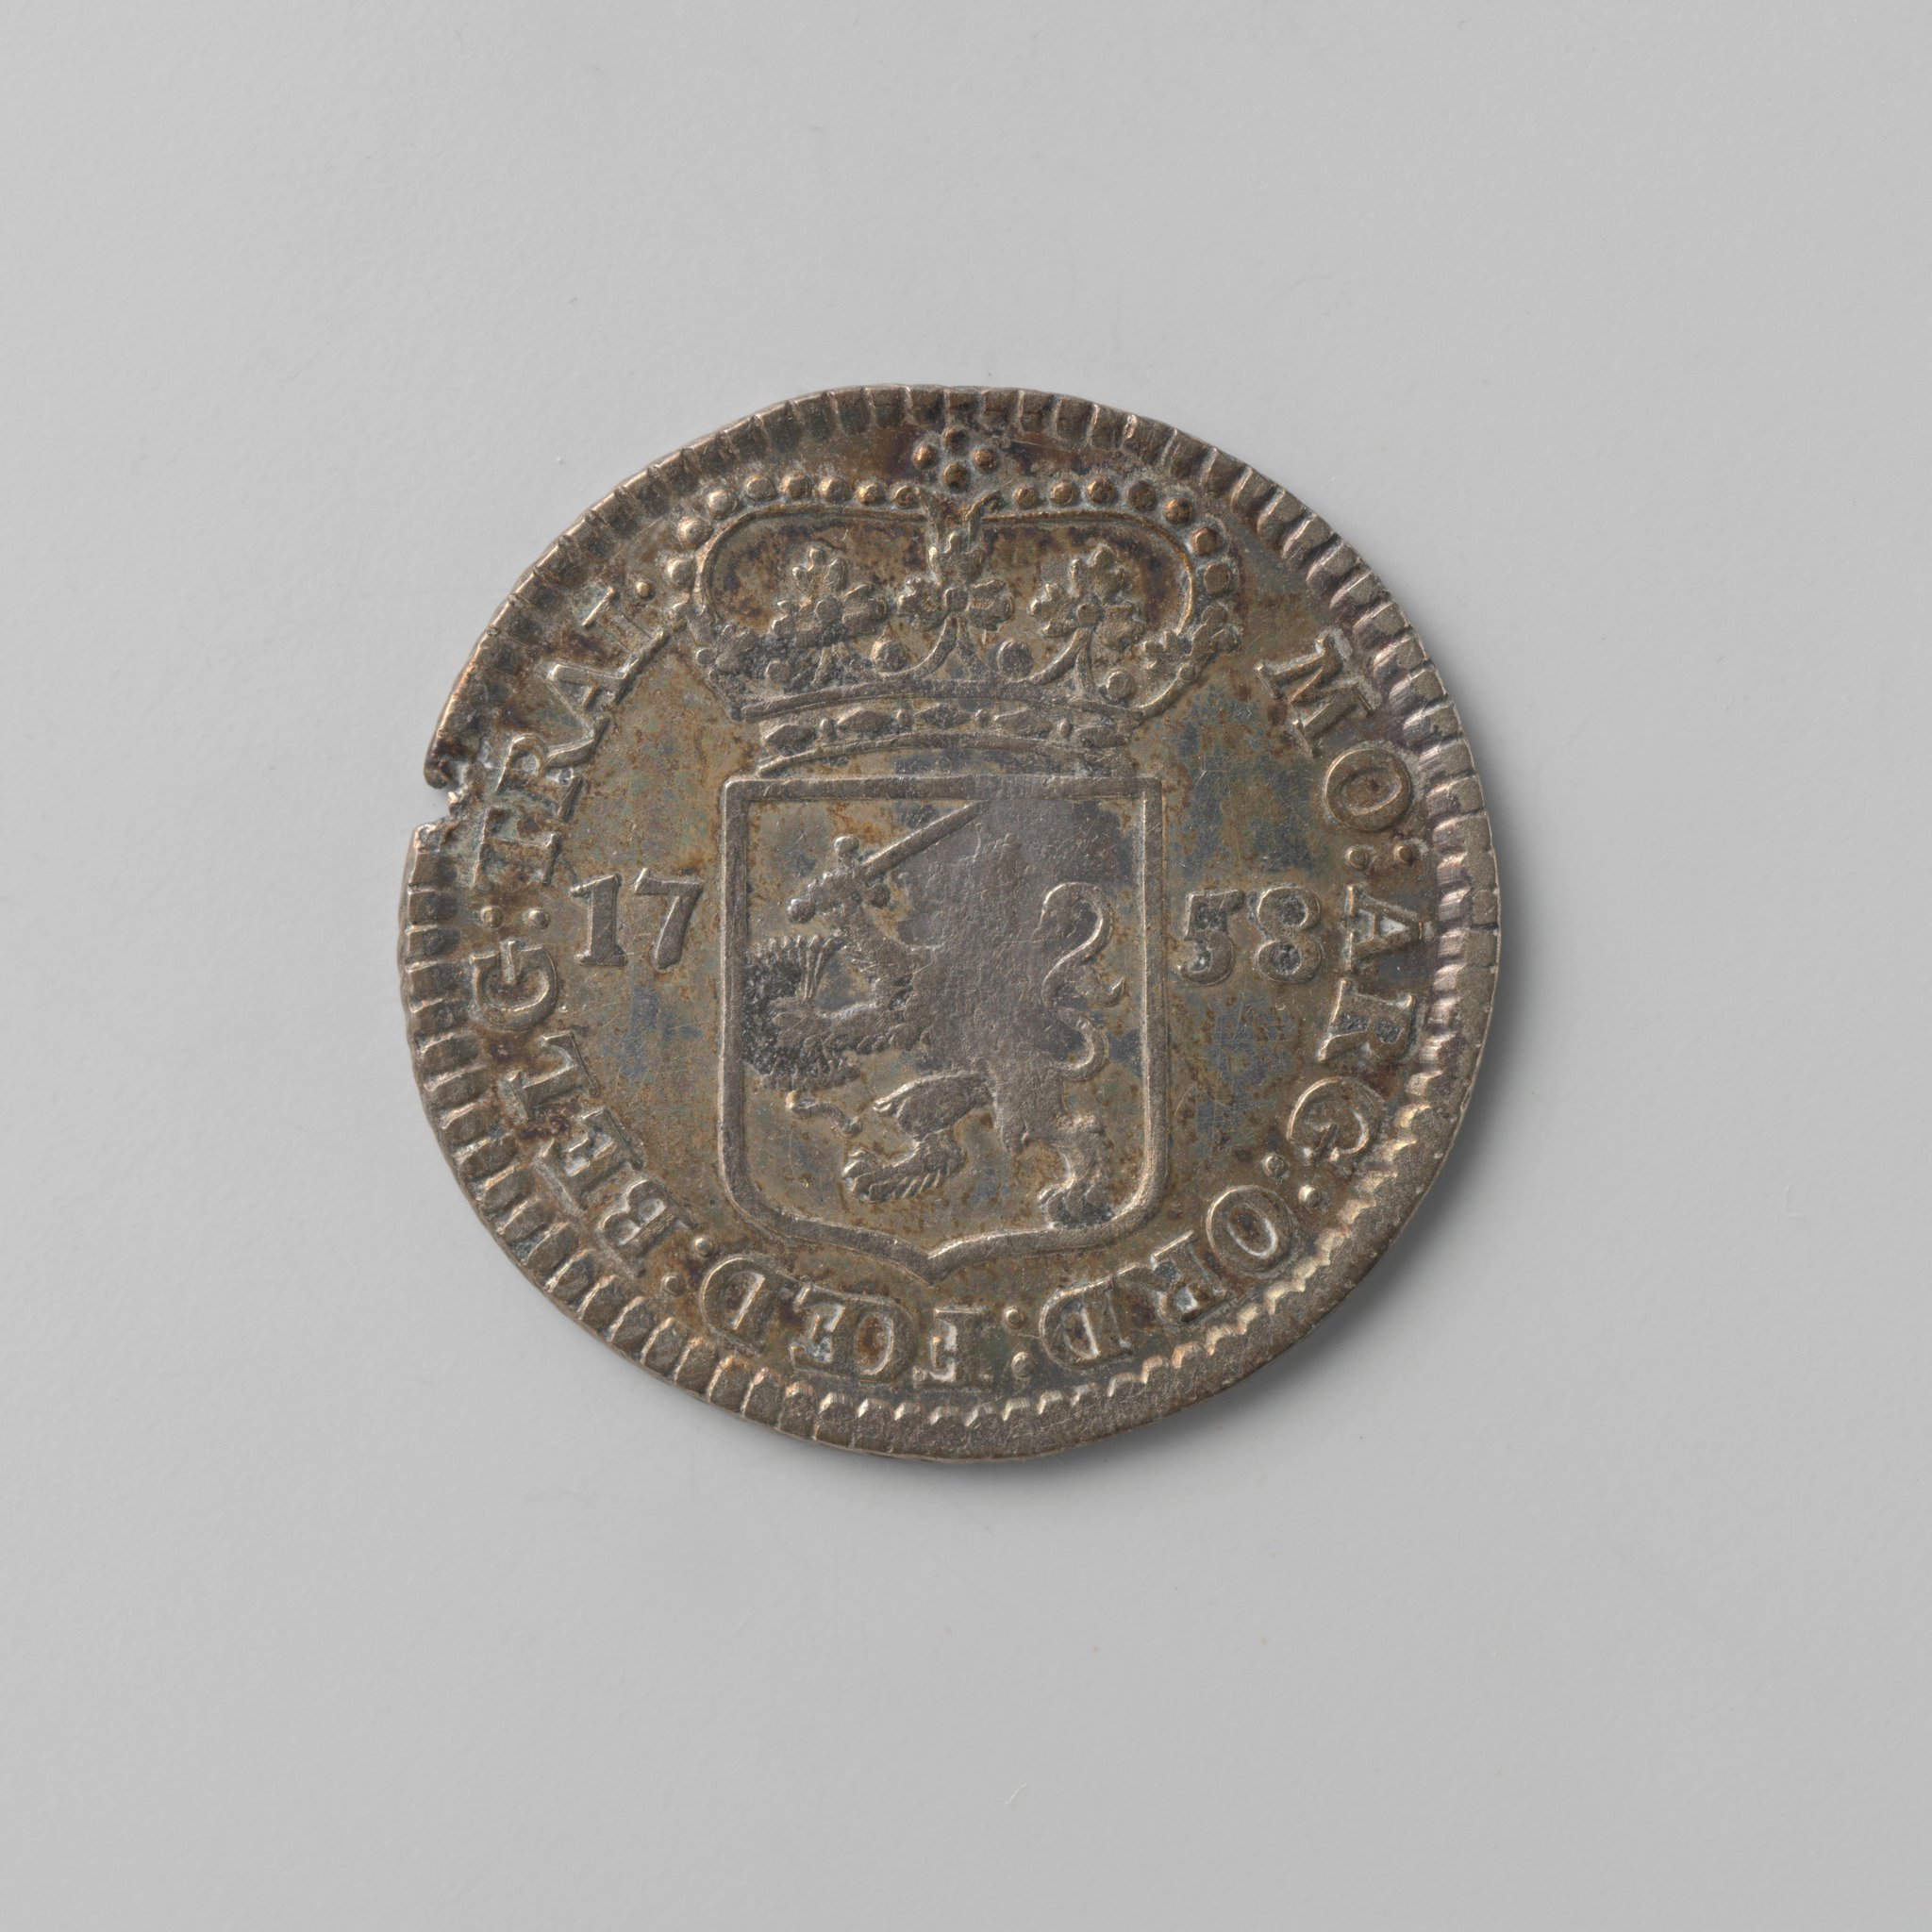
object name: coin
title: Utrechtse kwart gulden, 1758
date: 1758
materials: silver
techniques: striking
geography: utrecht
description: Zilveren munt. Voorzijde: tussen jaartal gekroond generaliteirtswapenschild. Keerzijde: Nederlandse maagd met vrijheidshoed en speer, leunend op een bijbel op een altaar. Kabelrand. Zogenaamde muntmeesterspenning.